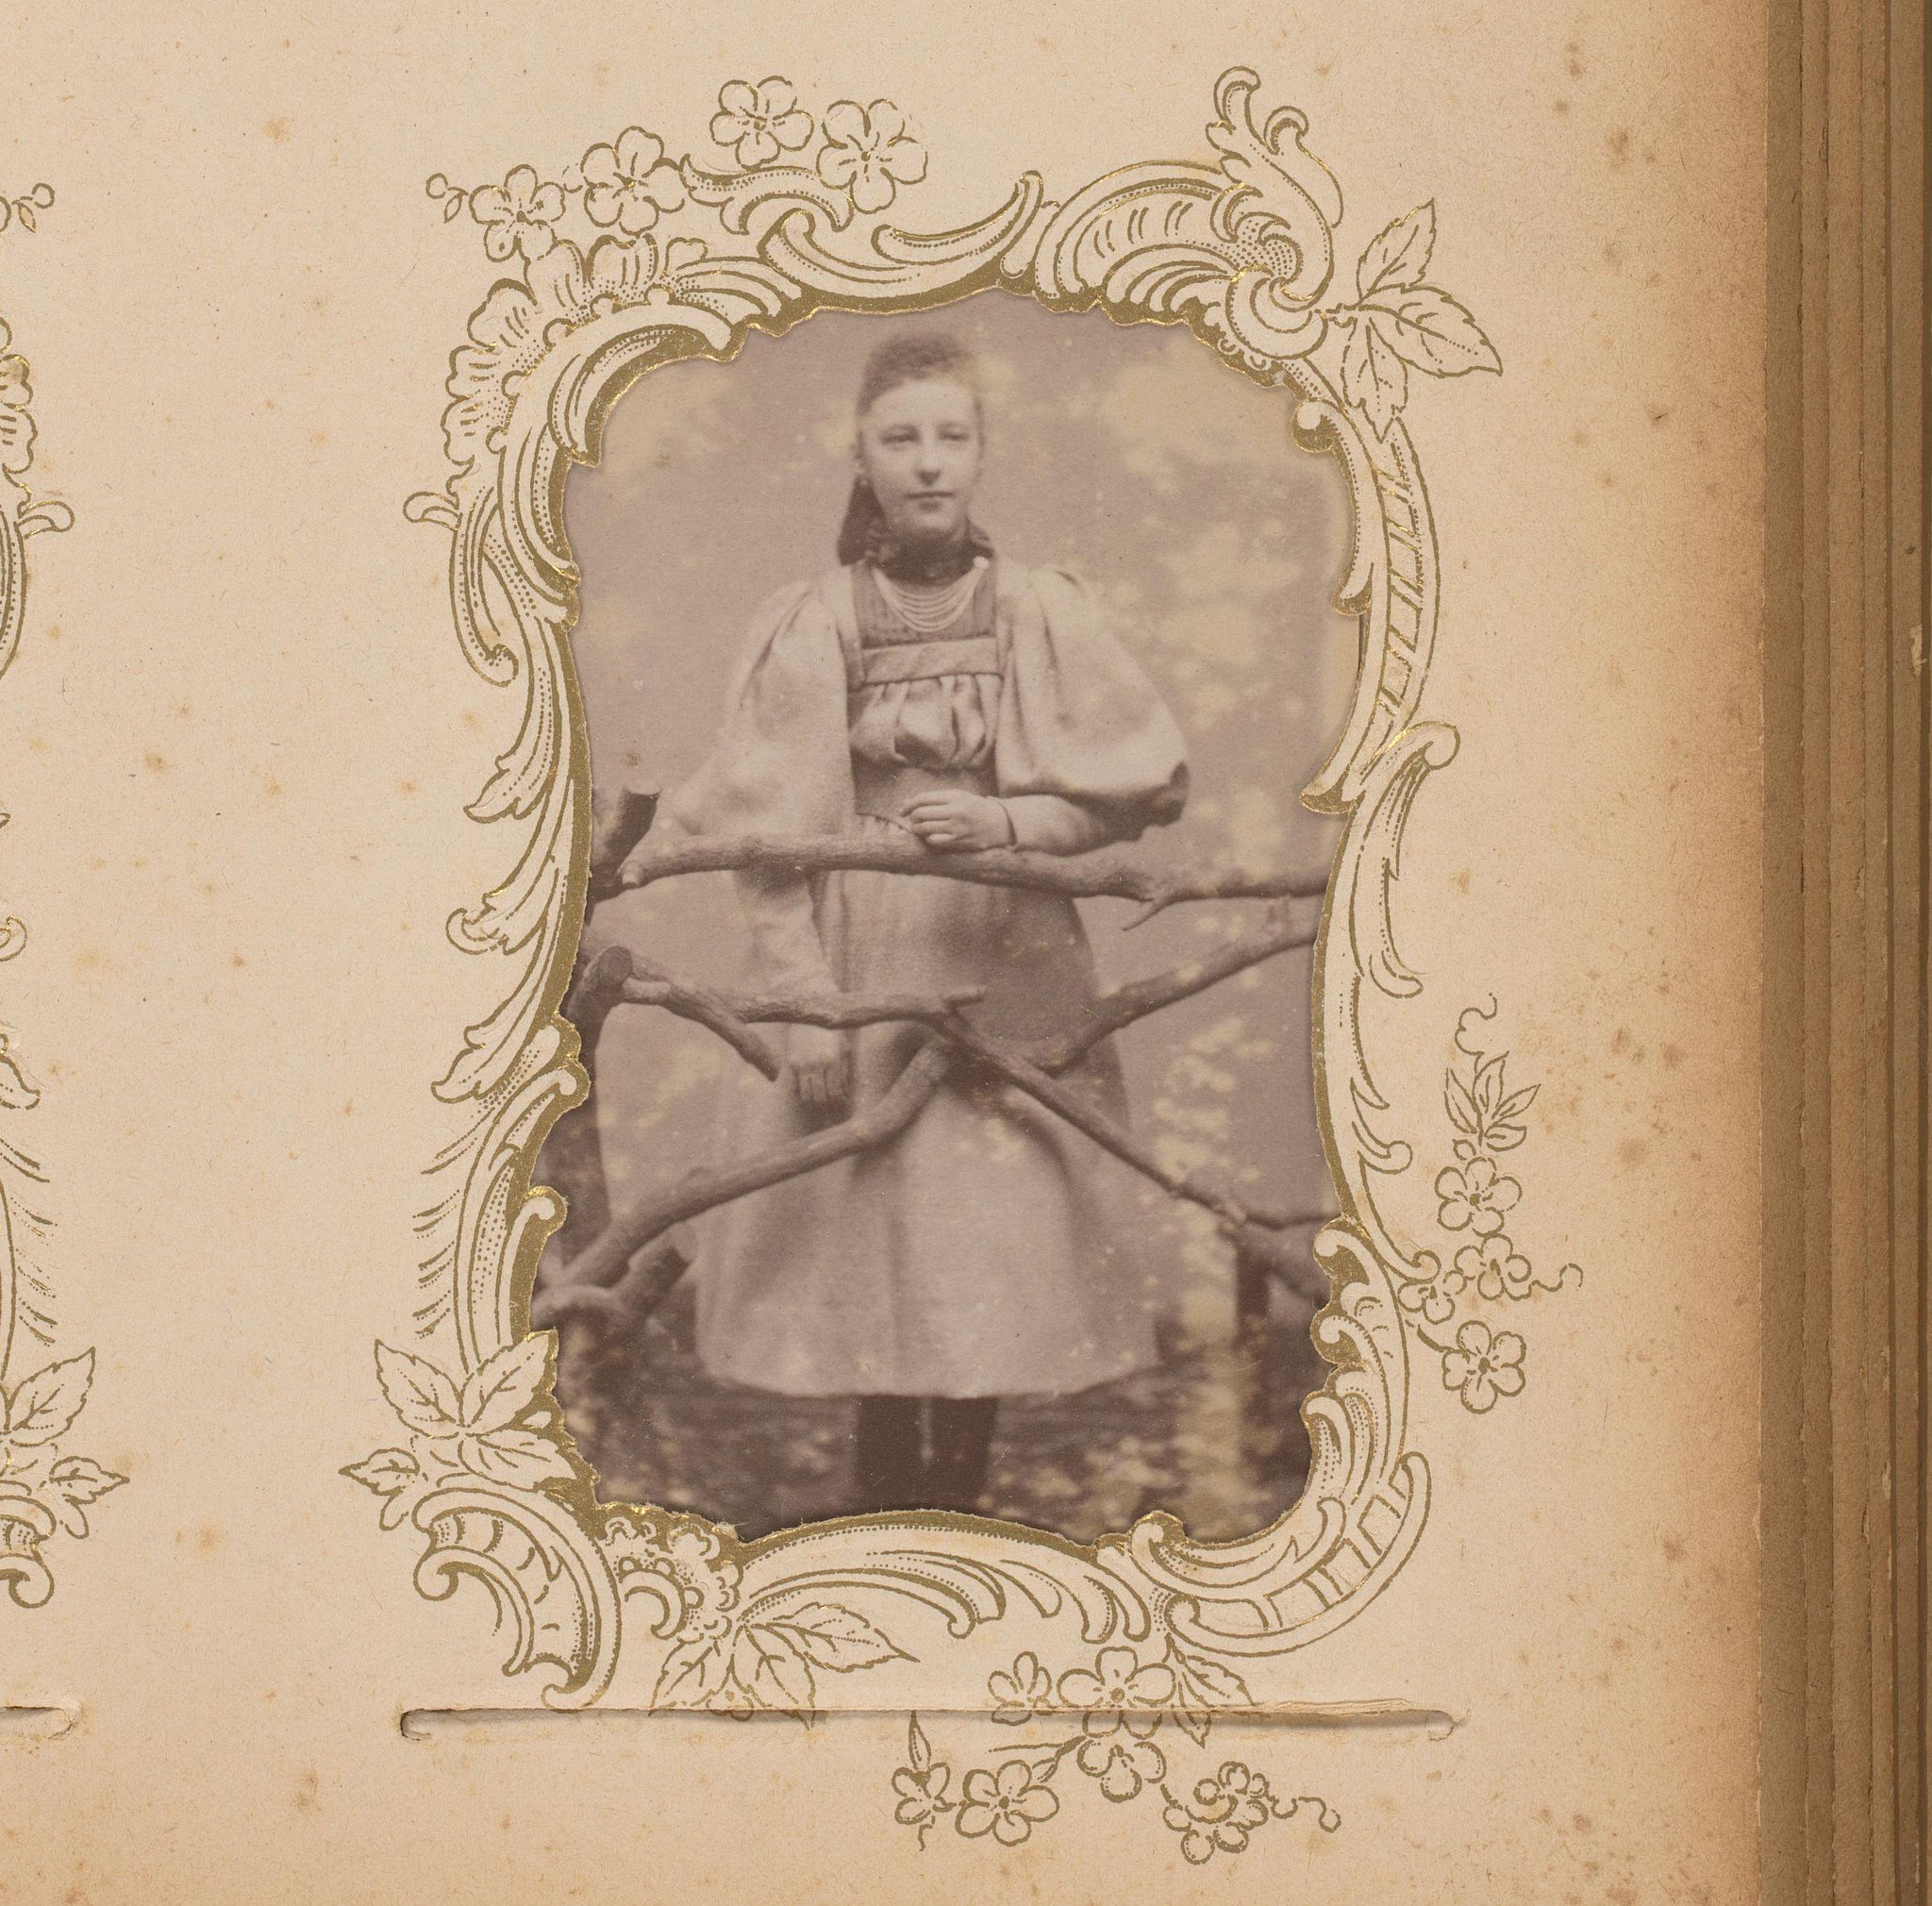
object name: carte de visite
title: Portret van een meisje, staand bij een hek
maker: Anonymous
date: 1860-1890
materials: cardboard, photographic support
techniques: albumen print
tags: historical persons - bb - woman, girl (child between toddler and youth), standing figure - aa - female human figure